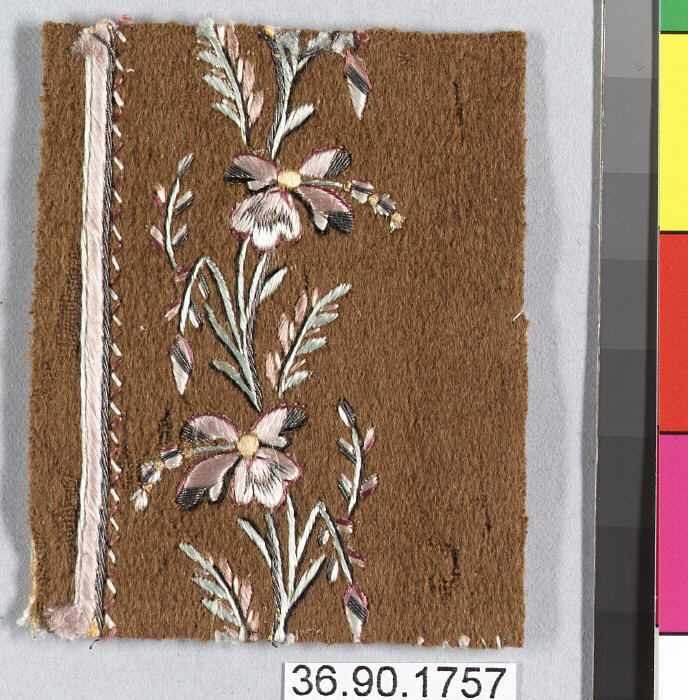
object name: sample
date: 1801-1833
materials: felt, metal thread, silk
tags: flowers